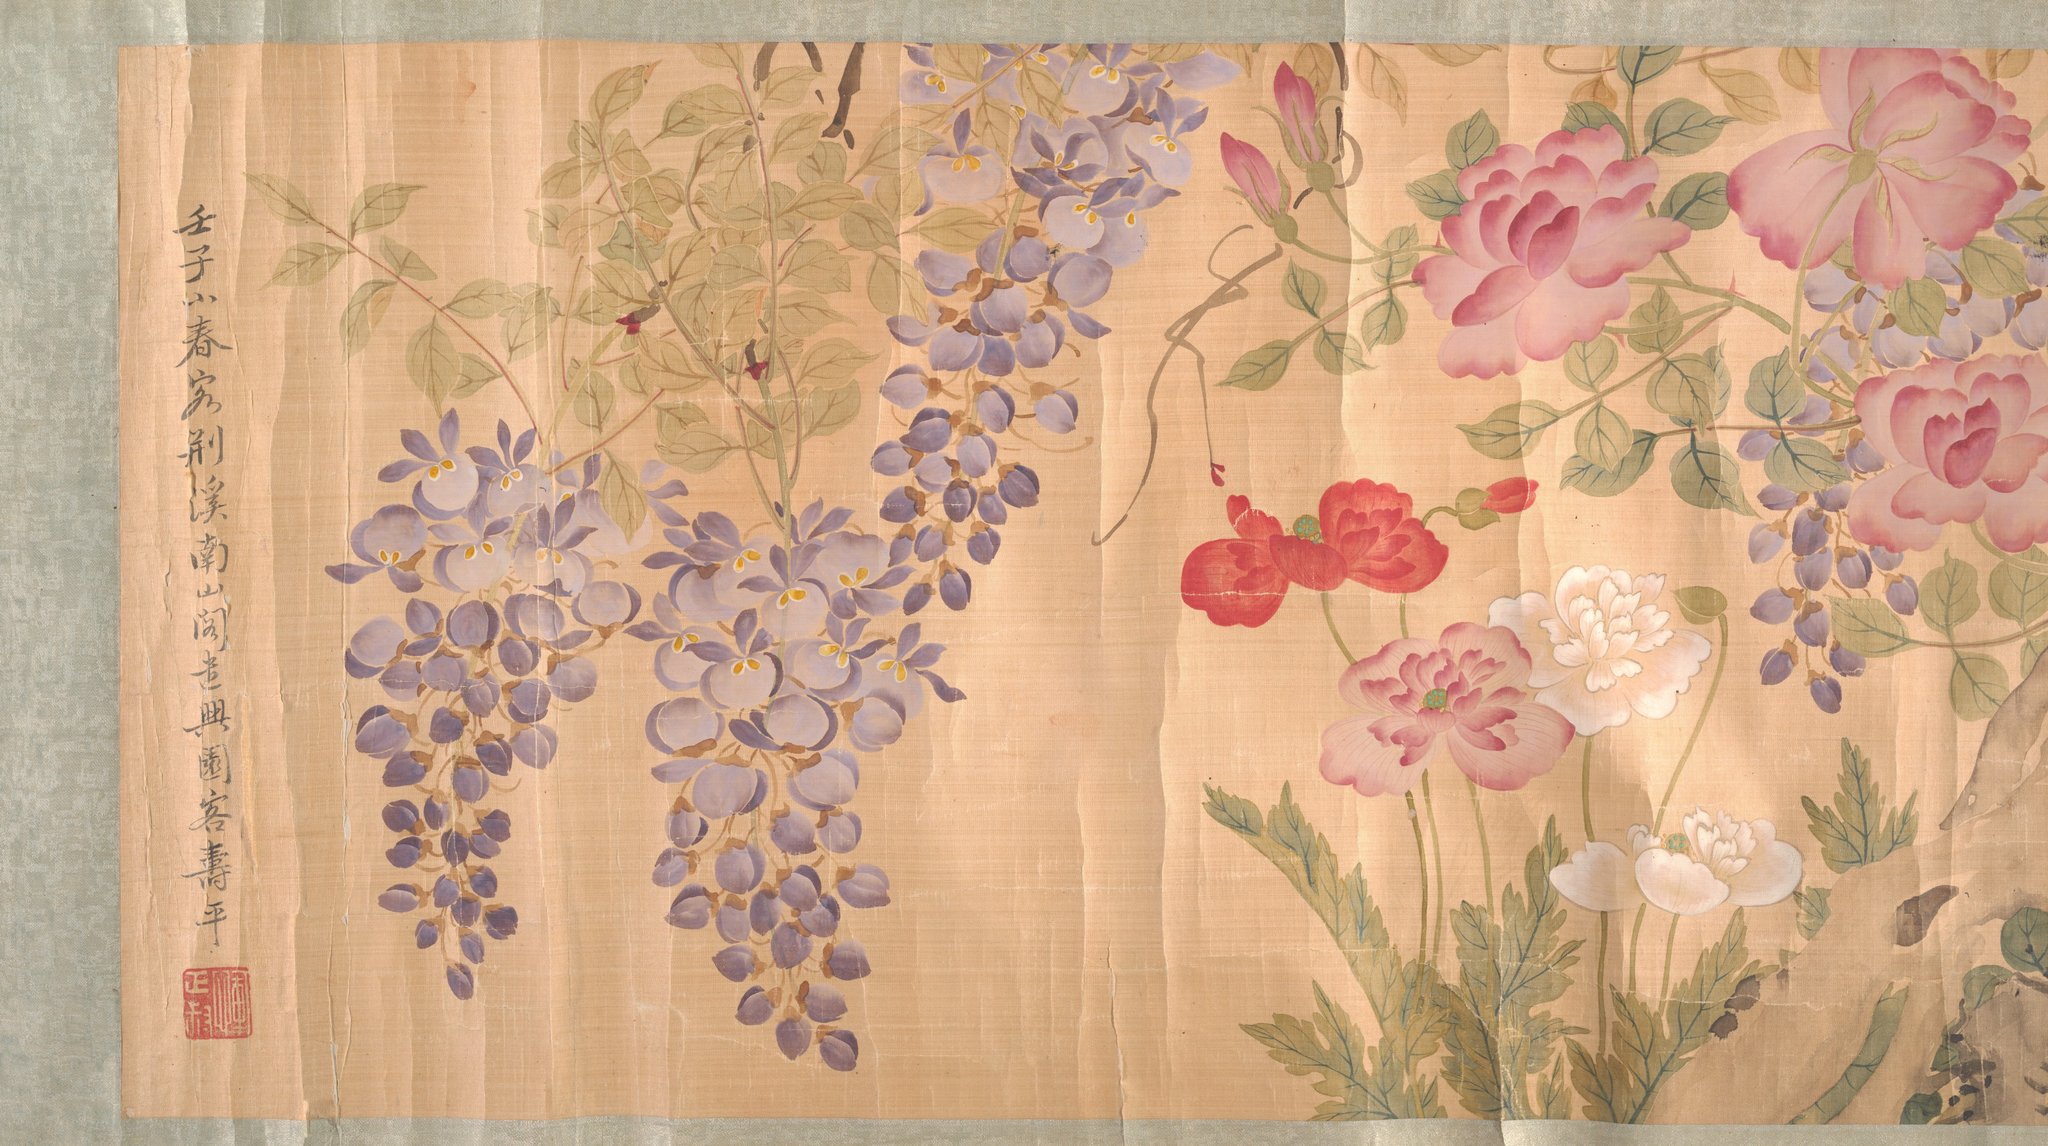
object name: handscroll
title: Roses and Wisteria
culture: chinese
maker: unidentified artist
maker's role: artist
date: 1701-1900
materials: ink, silk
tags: roses